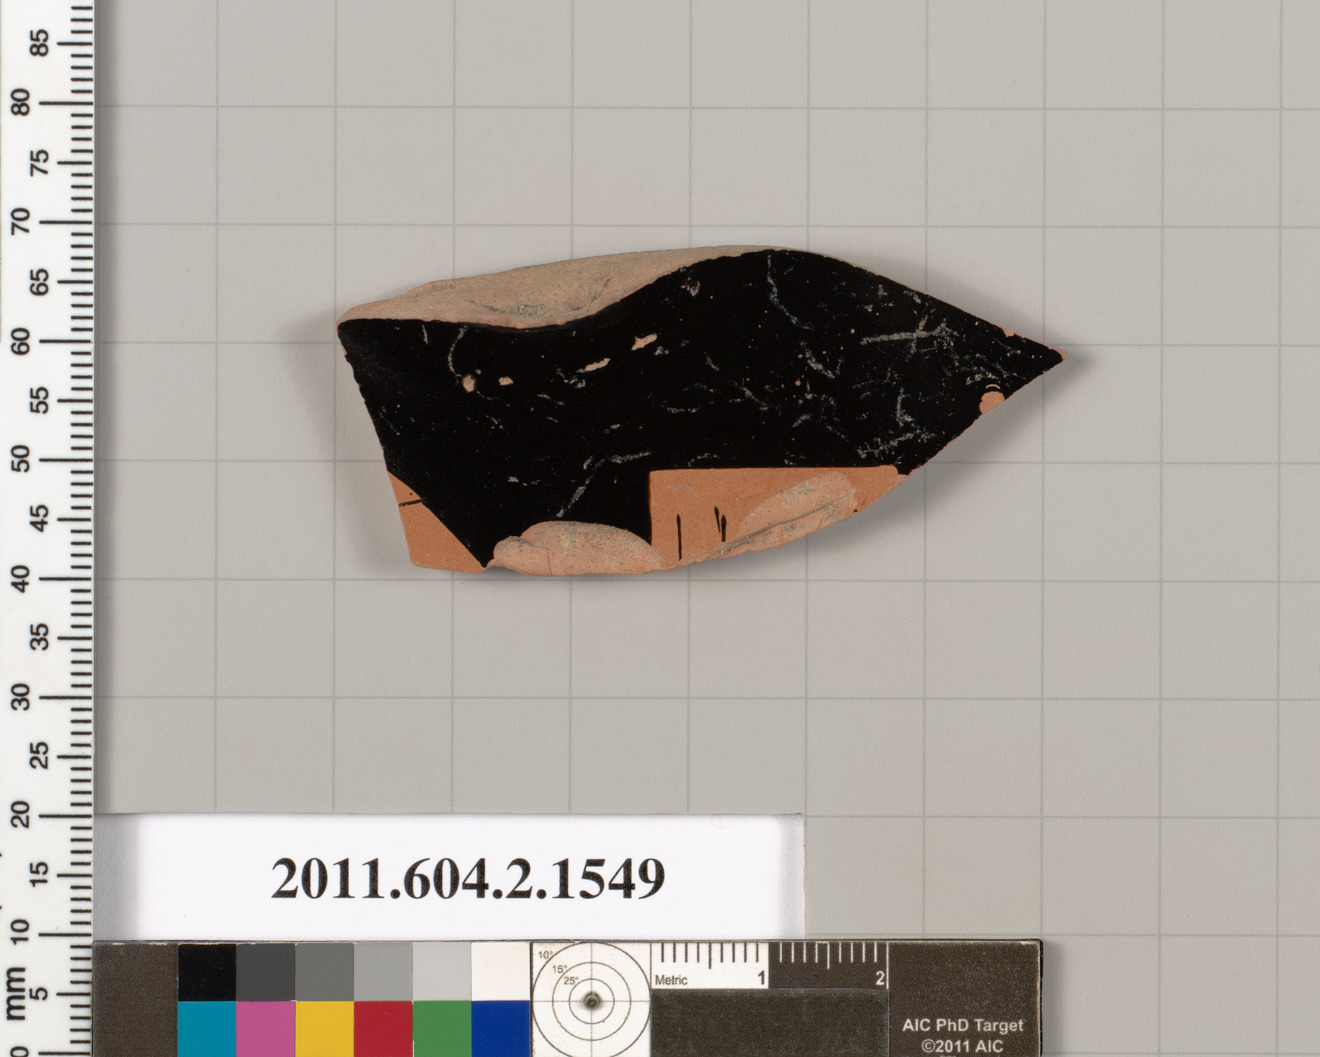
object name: skyphos fragment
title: Terracotta fragment of a skyphos (deep drinking cup)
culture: greek, attic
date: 450-426 BCE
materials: terracotta